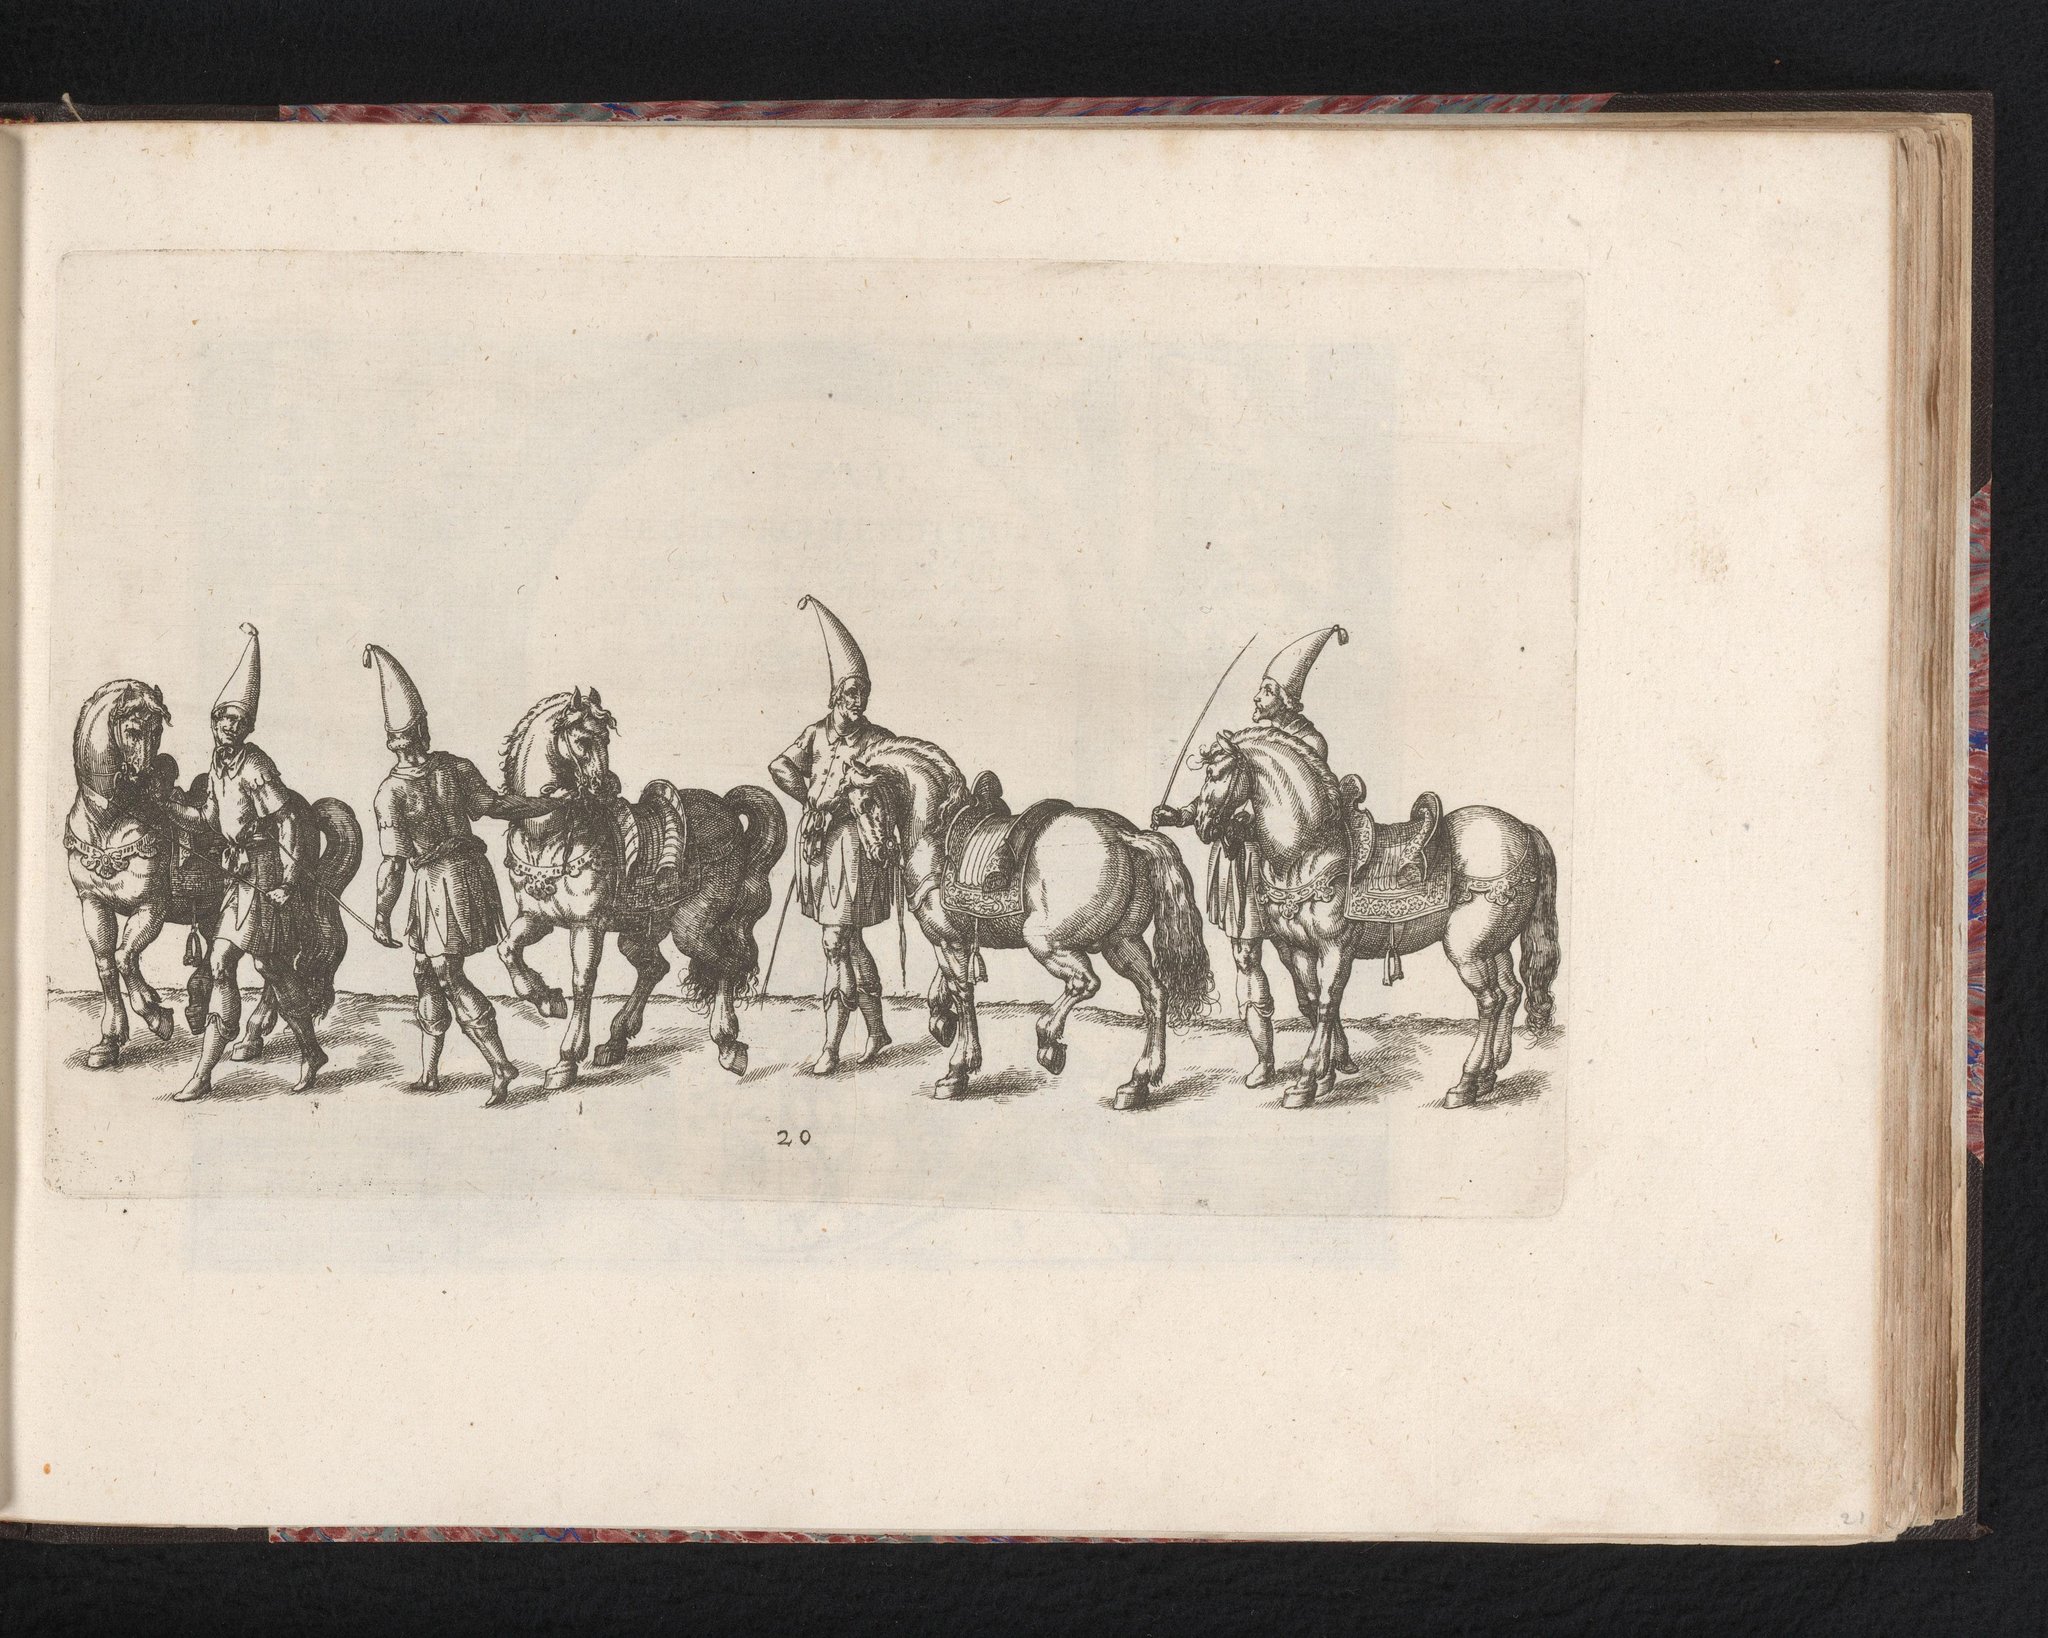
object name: print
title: Praalwagen met de personificaties van Tijd en het Leven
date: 1618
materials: paper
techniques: etching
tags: human life; 'vita humana', 'vita inquieta', 'vita e l'animo' (ripa), chariot, triumphal car, performance in the open air (pleasure fair), four-wheeled vehicle drawn by two animals, father time, man with wings and scythe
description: Genummerd: 19. Deze prent maakt deel uit van een album.